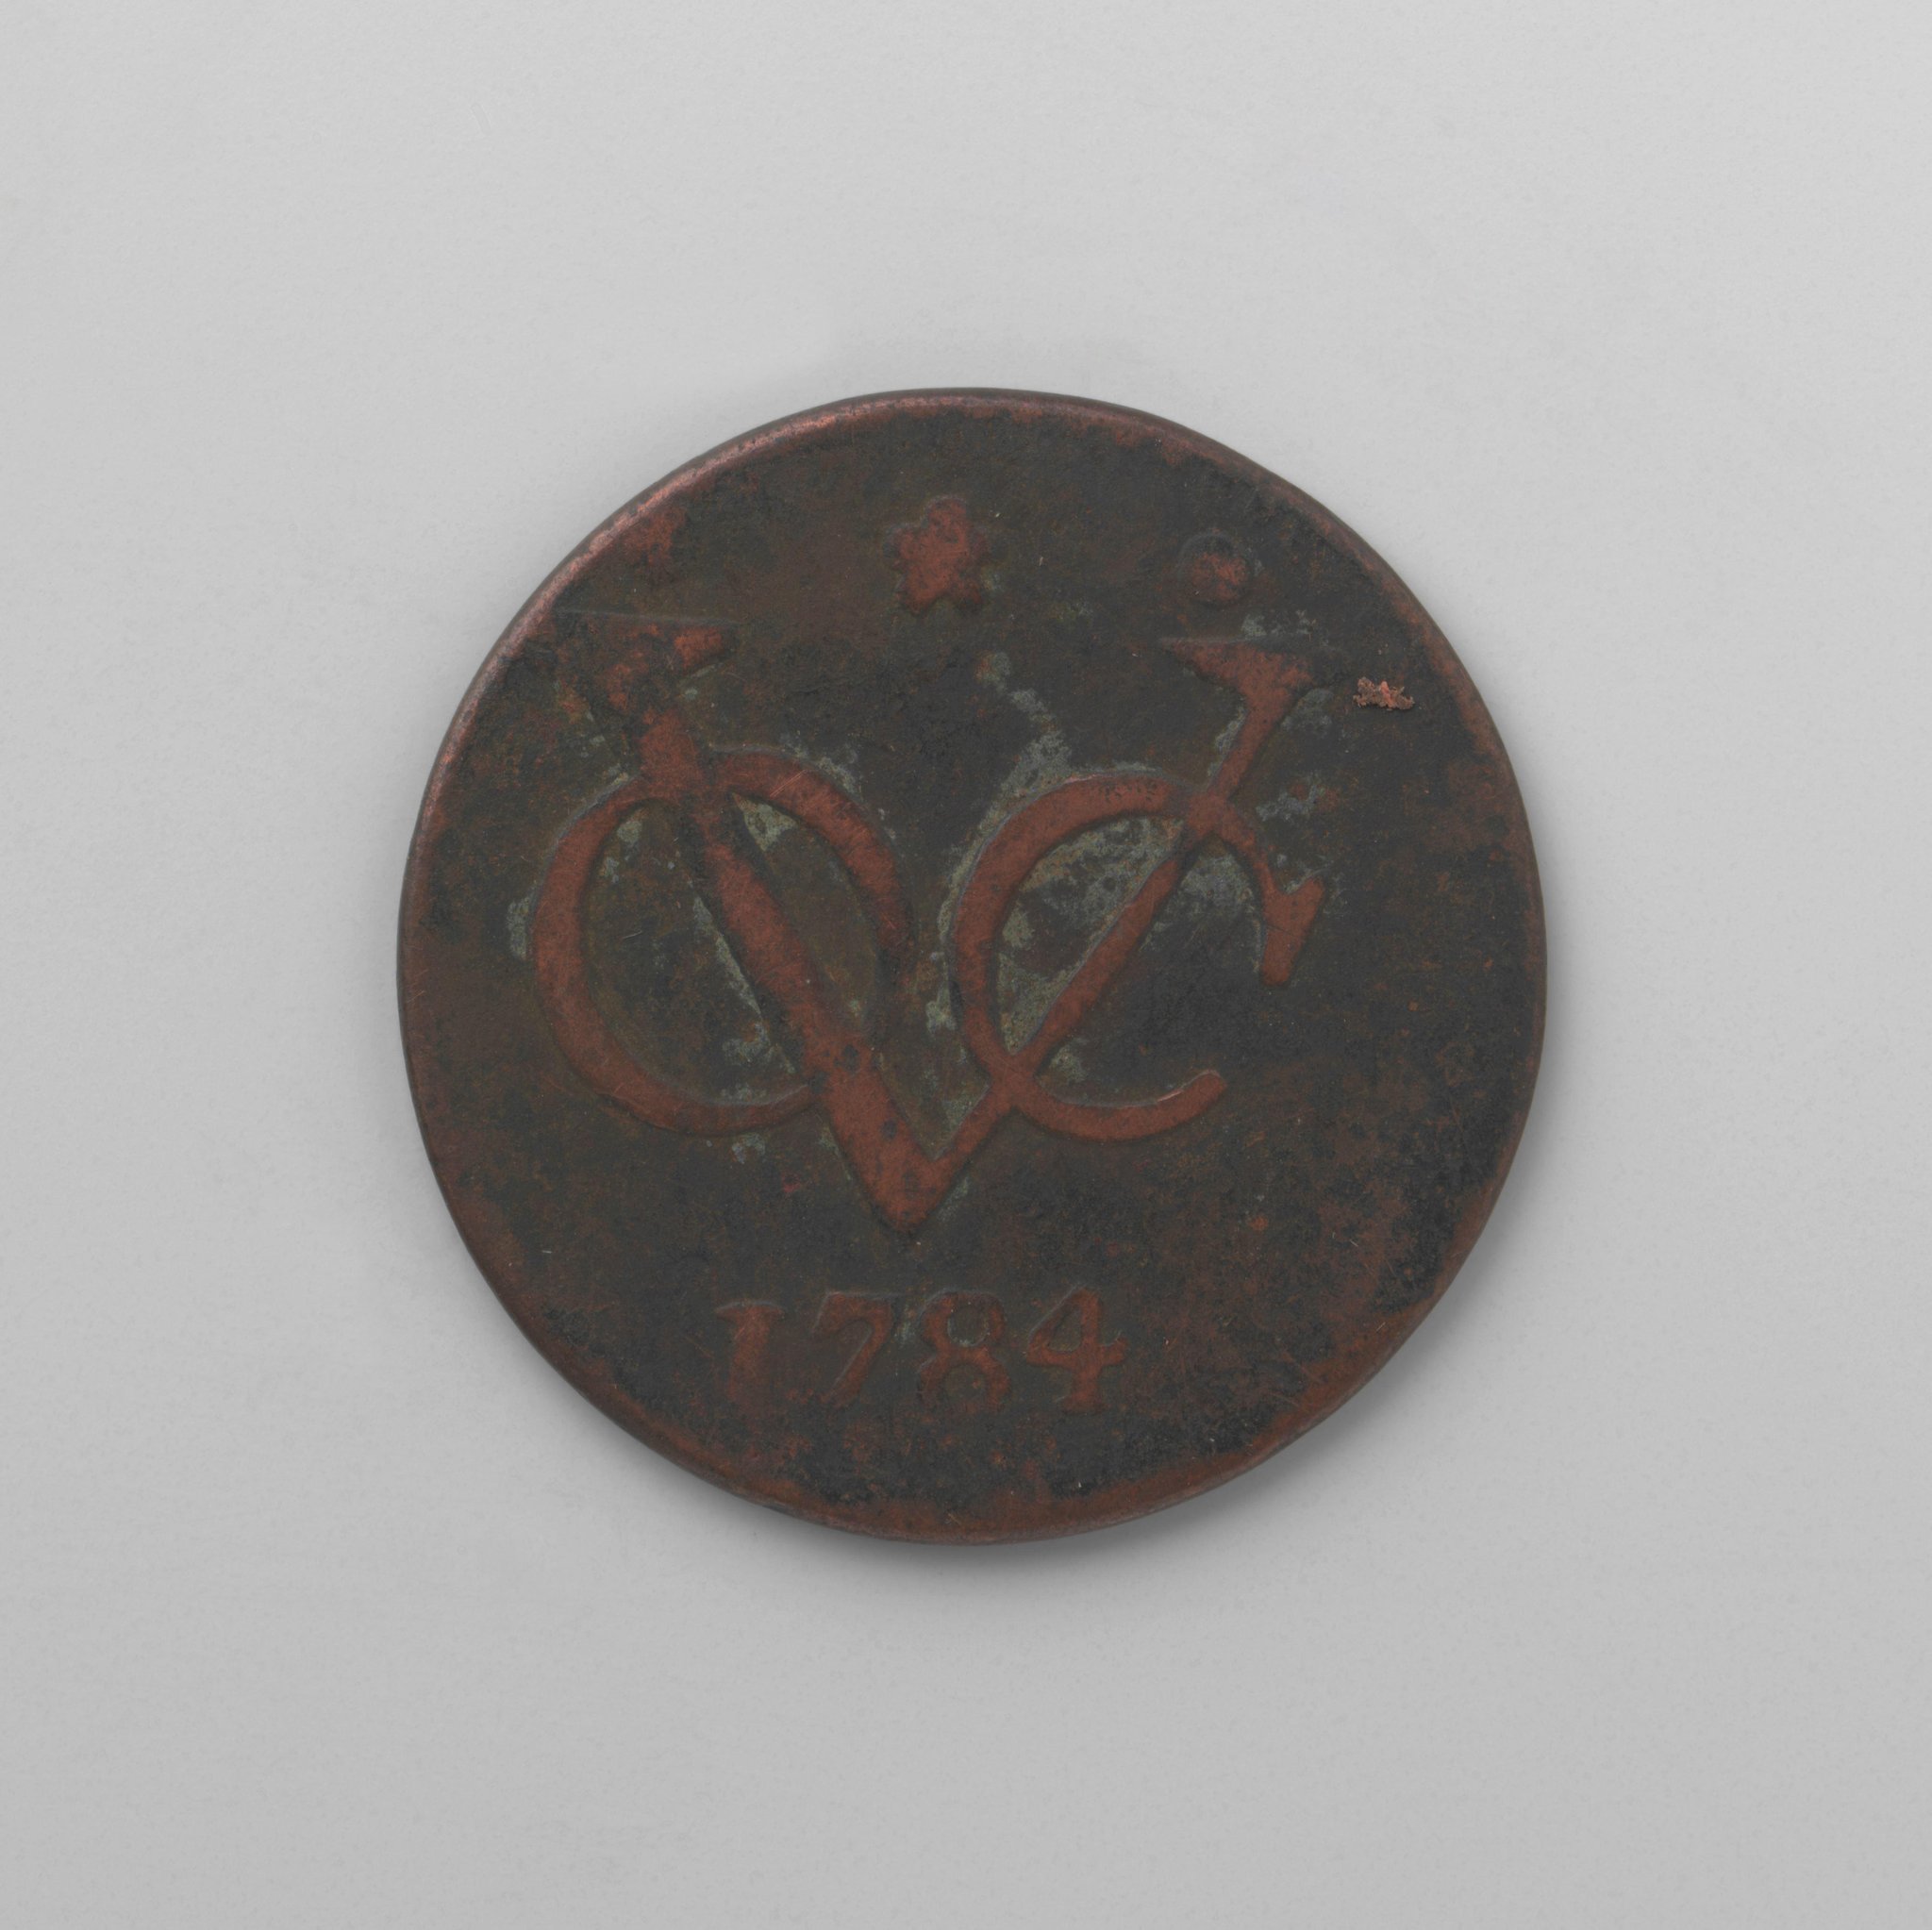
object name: coin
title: Duit van de VOC uit Westfriesland,1784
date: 1784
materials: copper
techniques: striking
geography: hoorn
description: Koperen munt. Voorzijde: gekroond wapenschild van Westfriesland. Keerzijde: monogram van de VOC, waarboven muntteken en waaronder jaartal. Gladde rand.